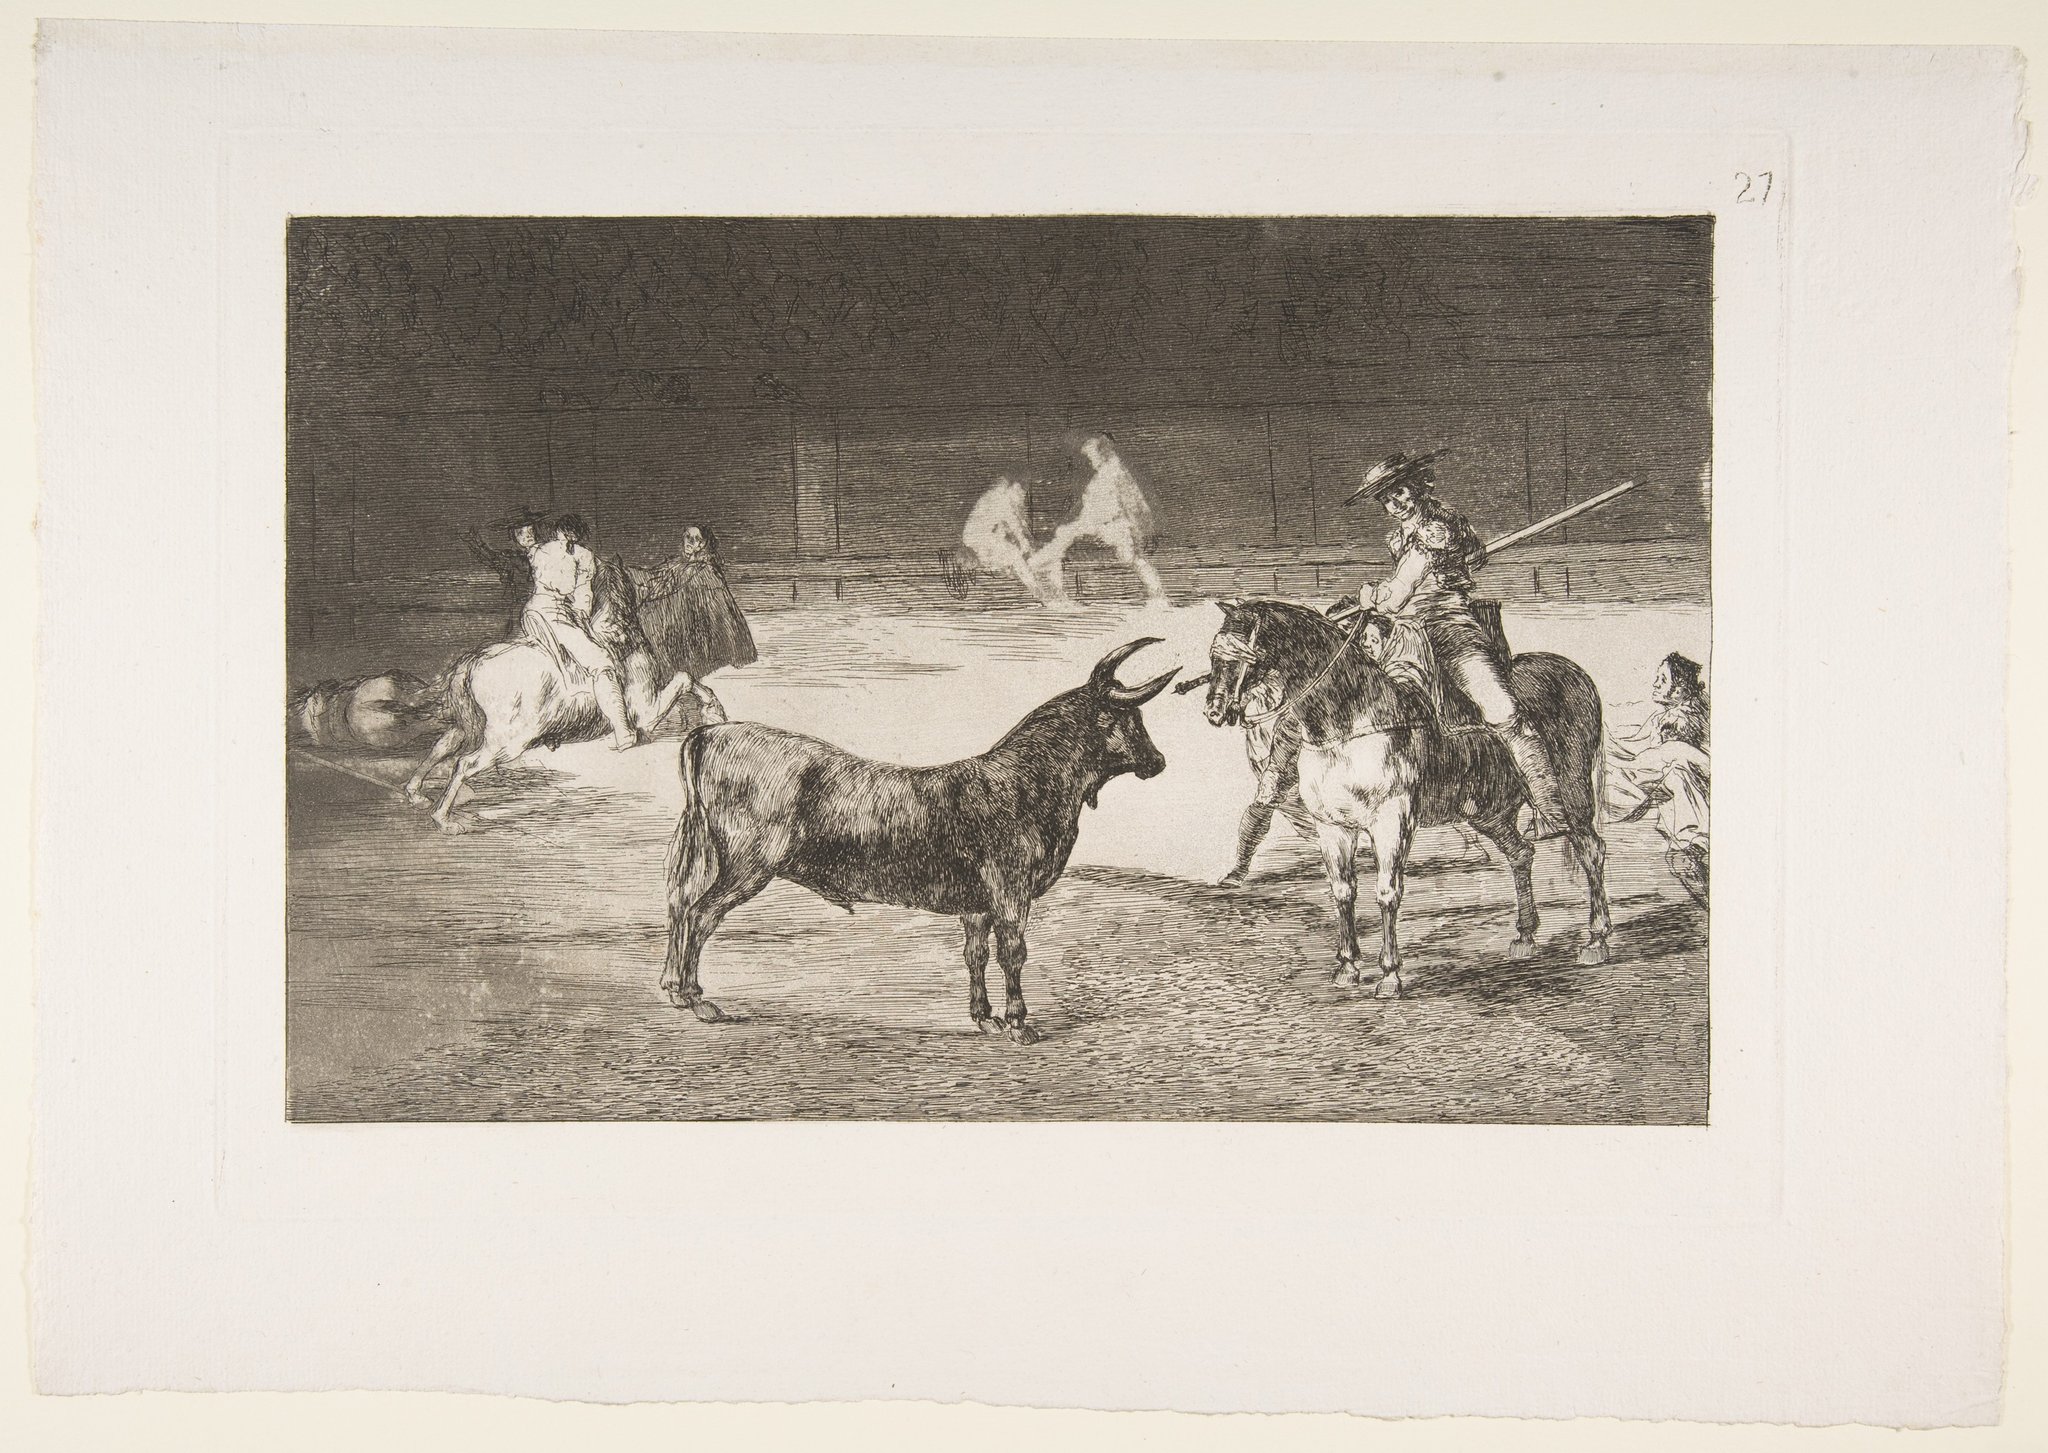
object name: print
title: Plate 27 from "La Tauromaquia": The celebrated picador, Fernando del Toro, draws the fierce beast on with his pike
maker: goya (francisco de goya y lucientes)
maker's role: artist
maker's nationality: spanish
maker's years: 1746-1828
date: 1816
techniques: aquatint, drypoint, etching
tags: men,bulls,horses